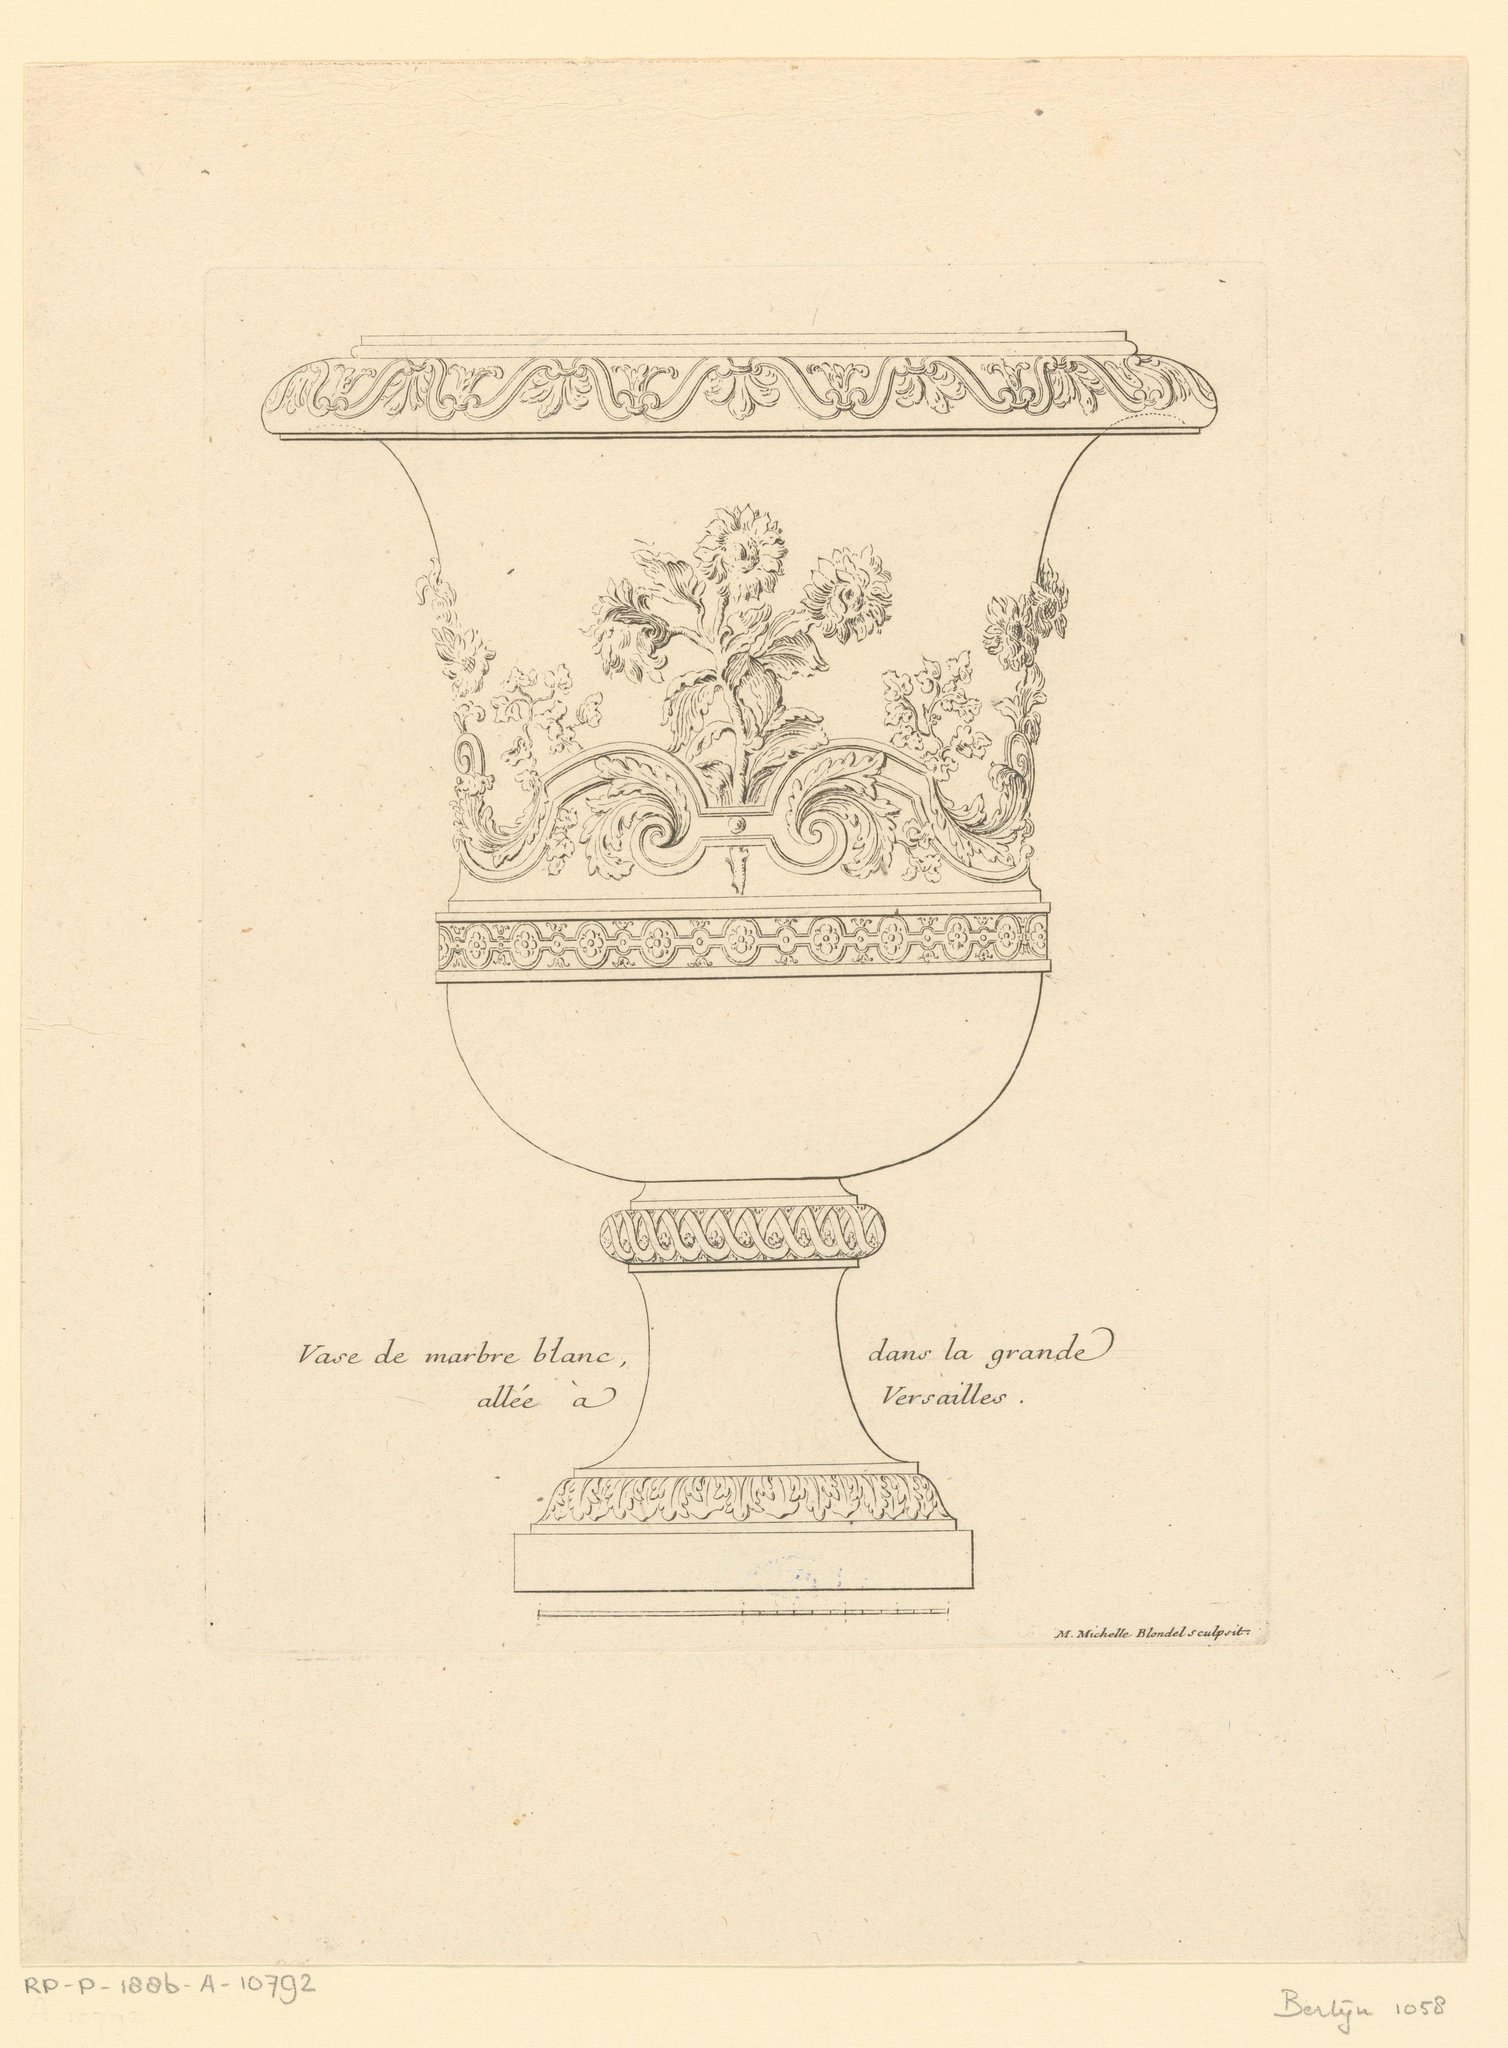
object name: print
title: Profils et ornemens de vases (...)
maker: marie michelle blondel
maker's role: print maker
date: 1723-1774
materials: paper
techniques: etching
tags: flowers ~ ornament, garden vase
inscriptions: collector's mark: Lugt 2228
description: Een geornamenteerde vaas met bloemmotieven. Met tweeregelige Franse tekst.